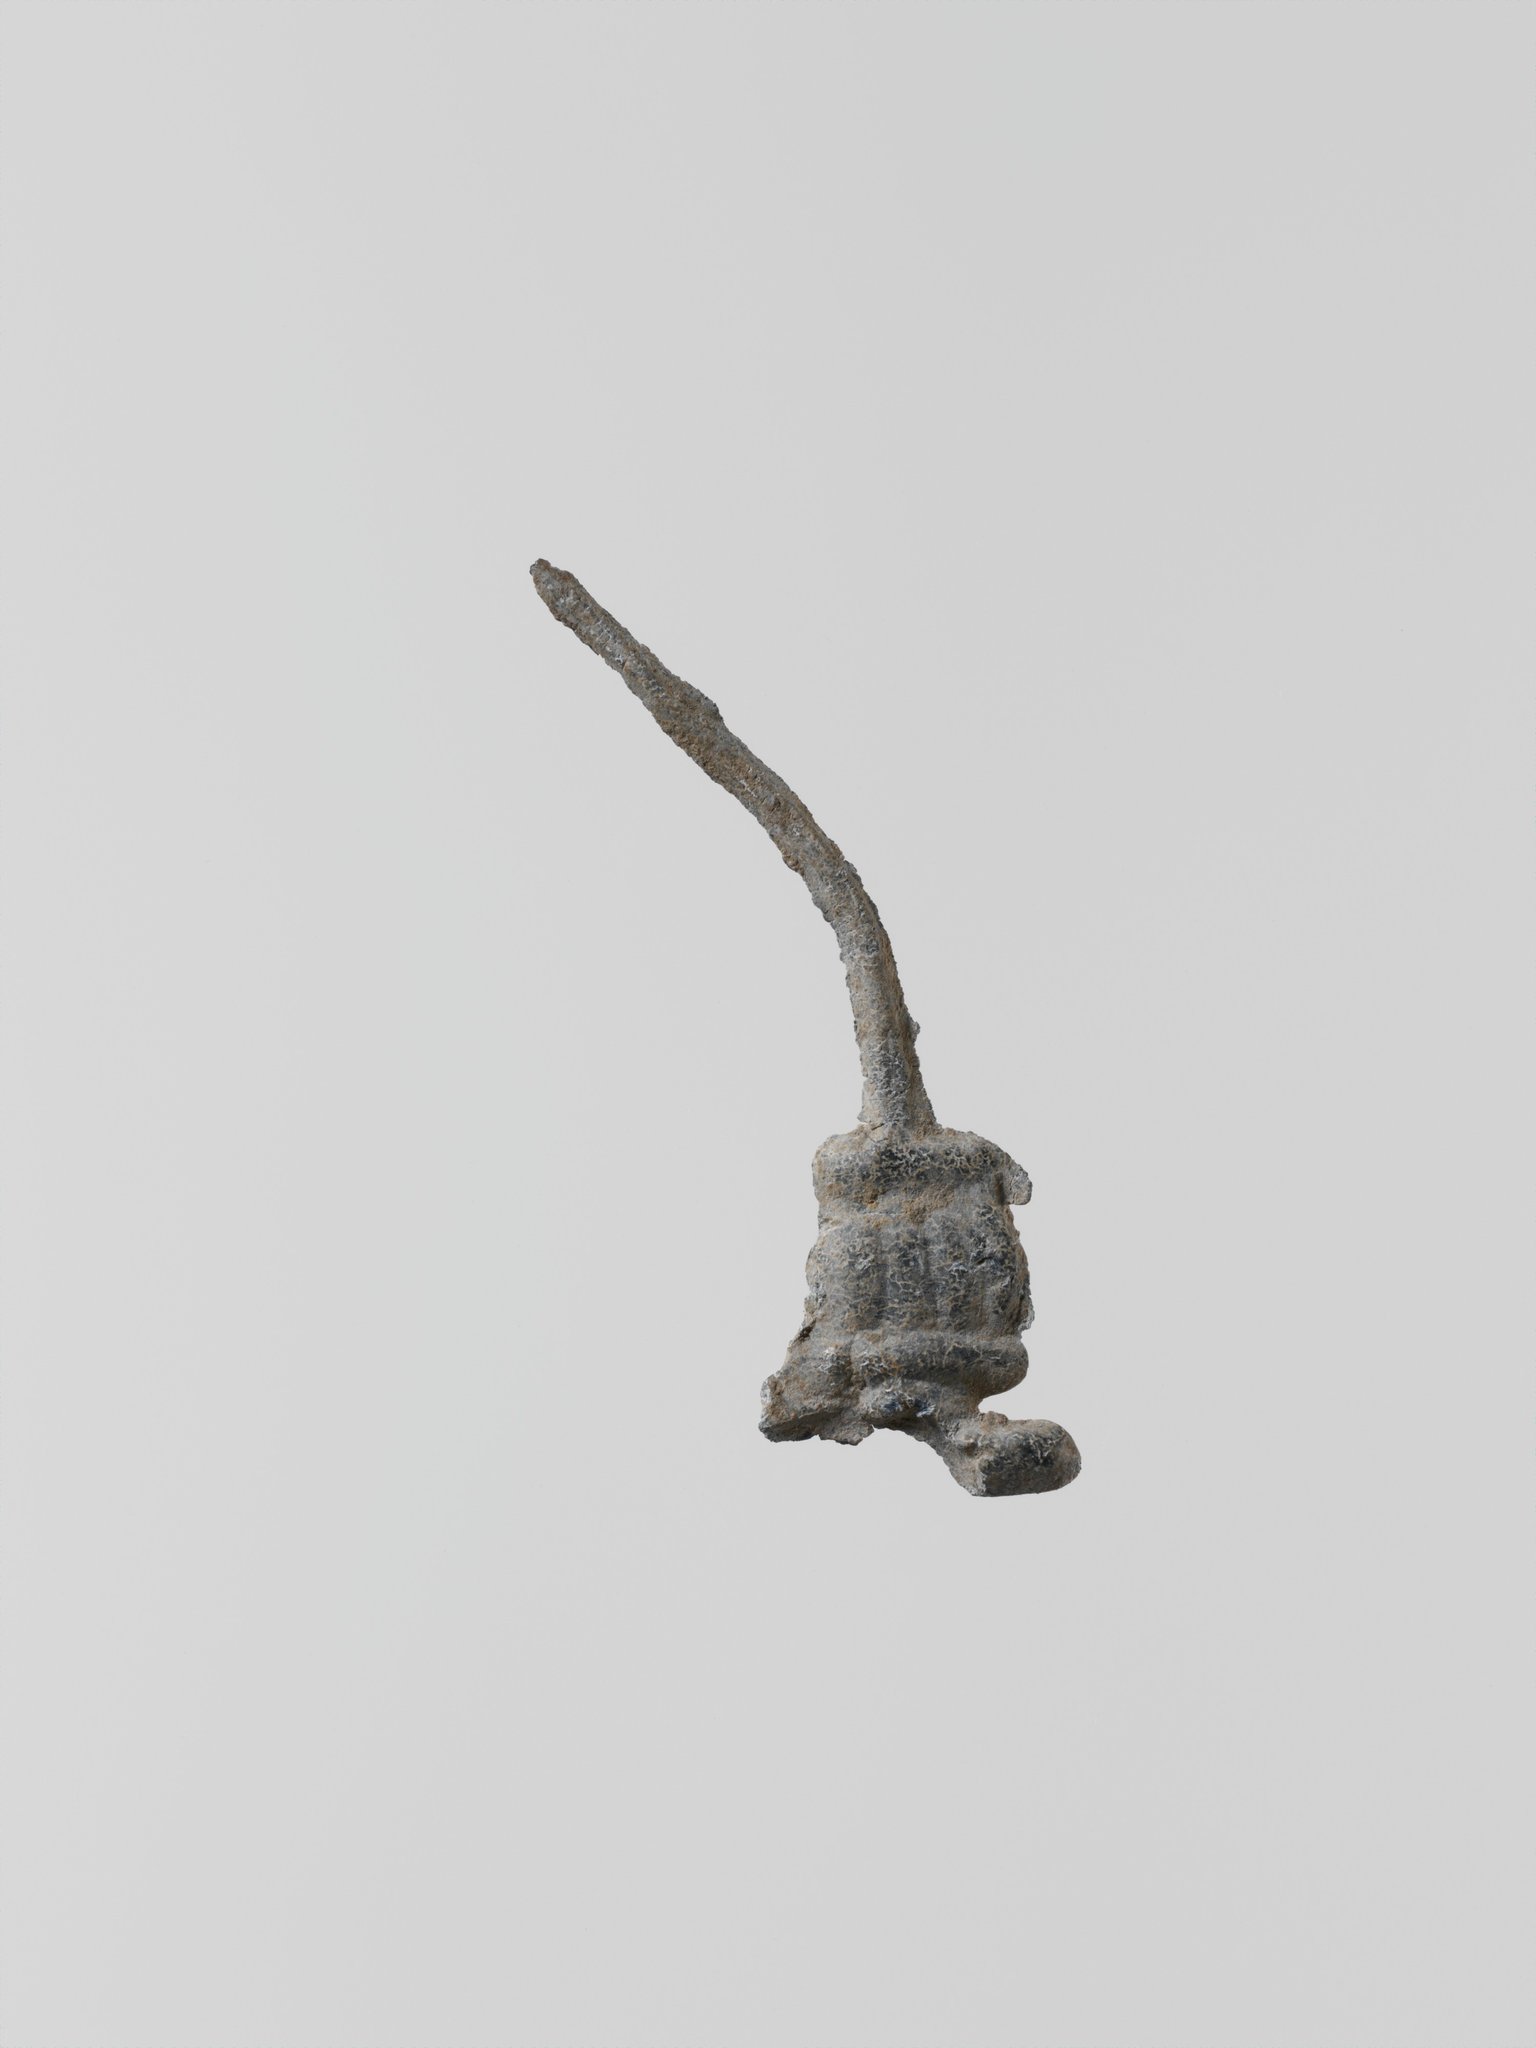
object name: ornament, 14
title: Ornaments, 14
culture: greek, laconian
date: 7000-30 BCE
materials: lead